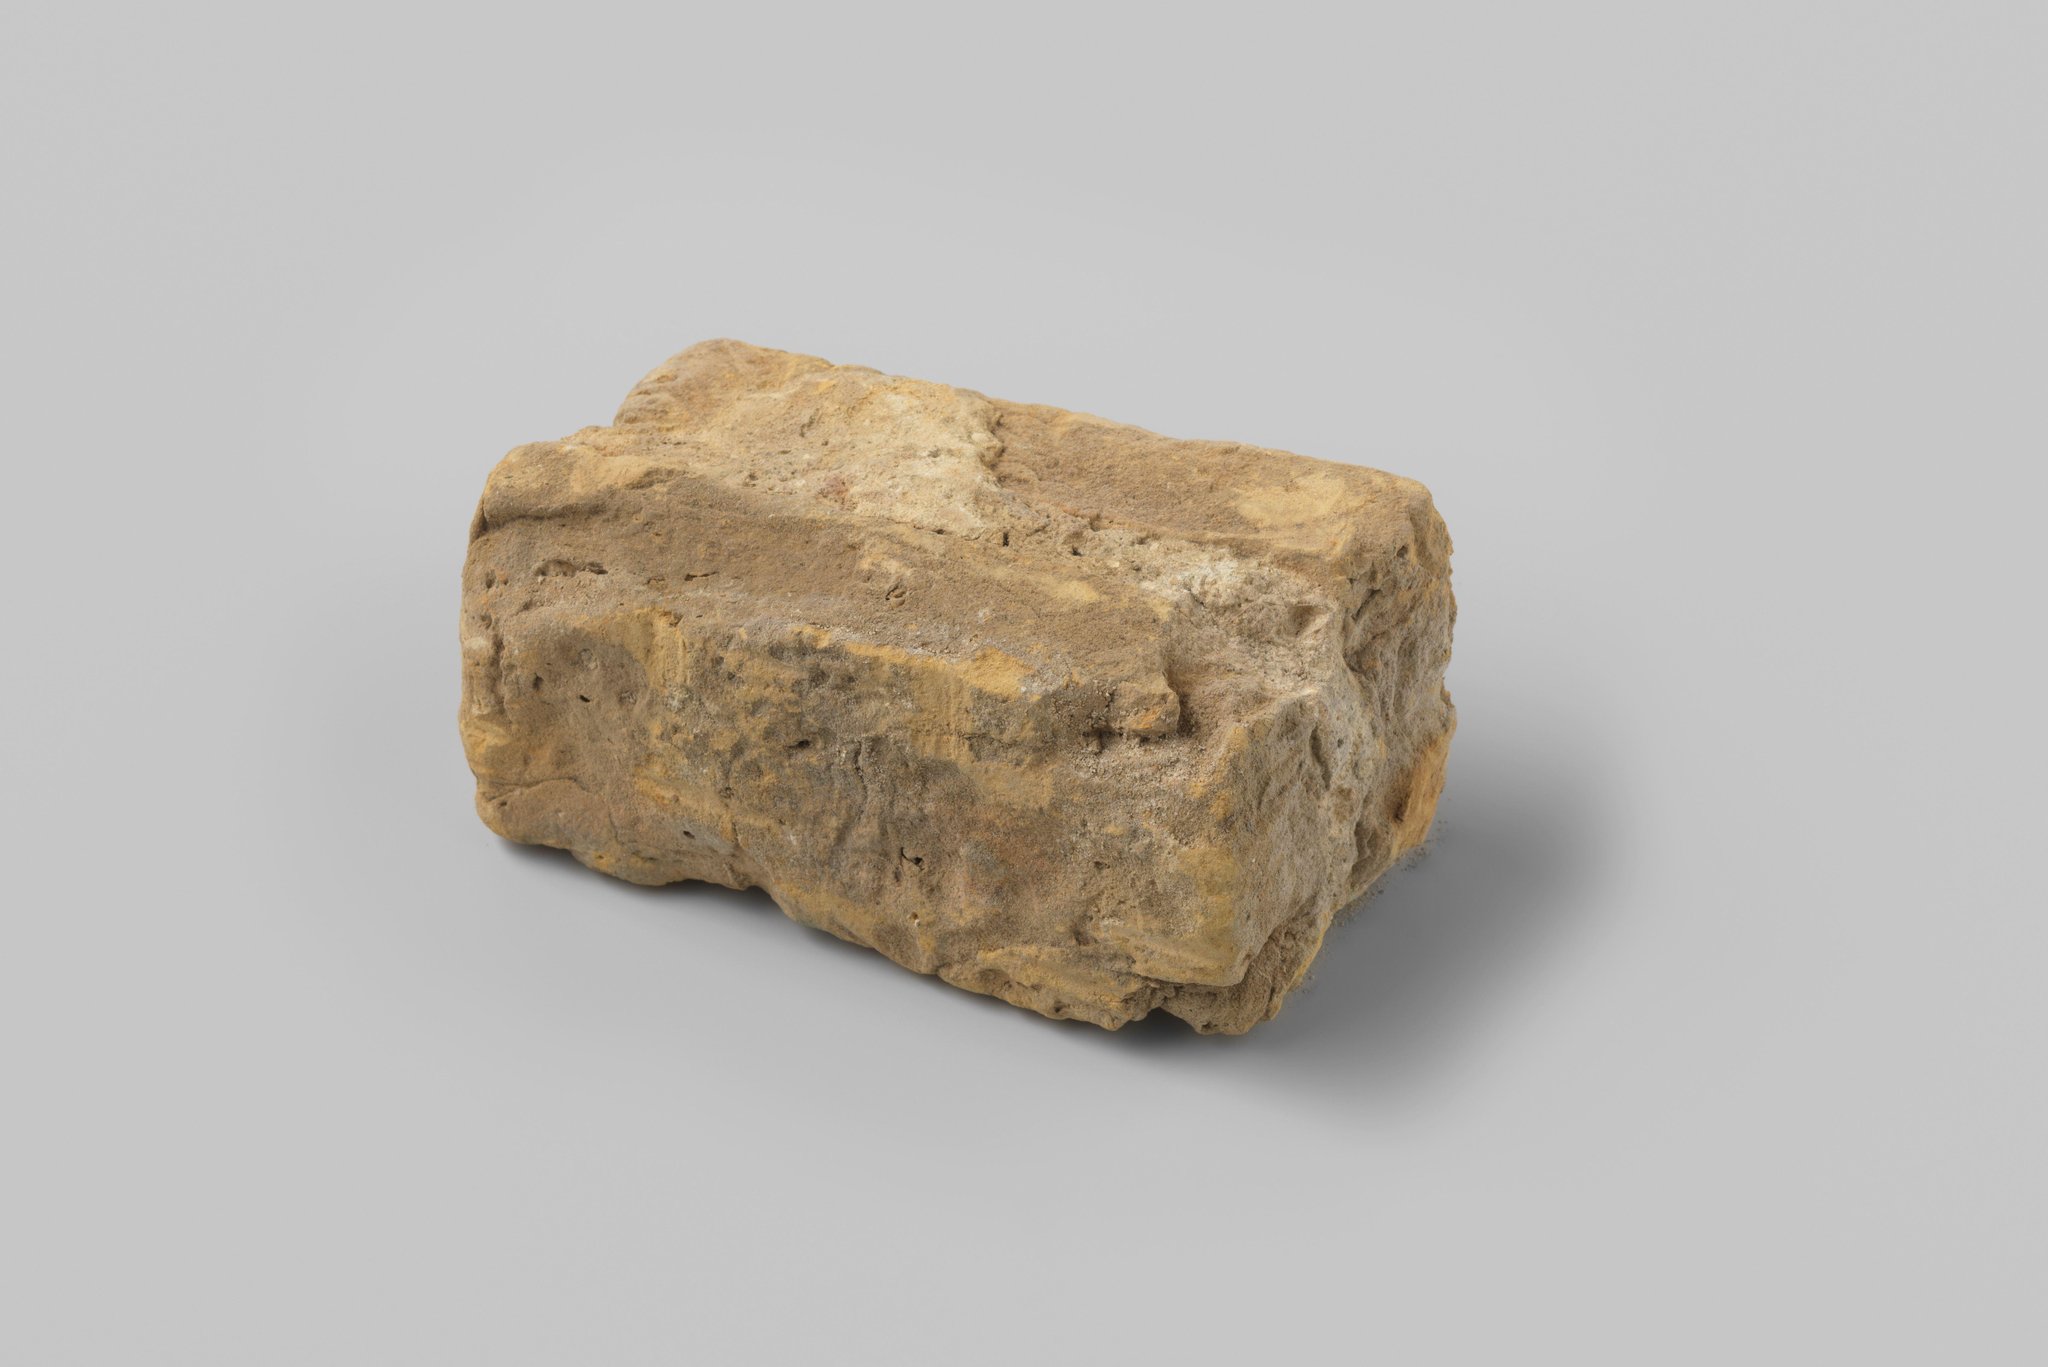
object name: brick clay product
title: Baksteen uit het wrak van de Oost-Indiëvaarder Princesse Maria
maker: Anonymous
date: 1682-1686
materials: brick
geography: netherlands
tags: princesse maria (schip), verenigde oostindische compagnie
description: Ca 20 hele en stukken van gele bakstenen, enkele door metselwerk verbonden. De bakstenen zijn veelal donker verkleurd (beroet) hetgeen erop wijst dat ze deel hebben uitgemaakt van de kombuis. En 80 hele en gebroken gele IJsselstenen of tichelstenen. Brick.